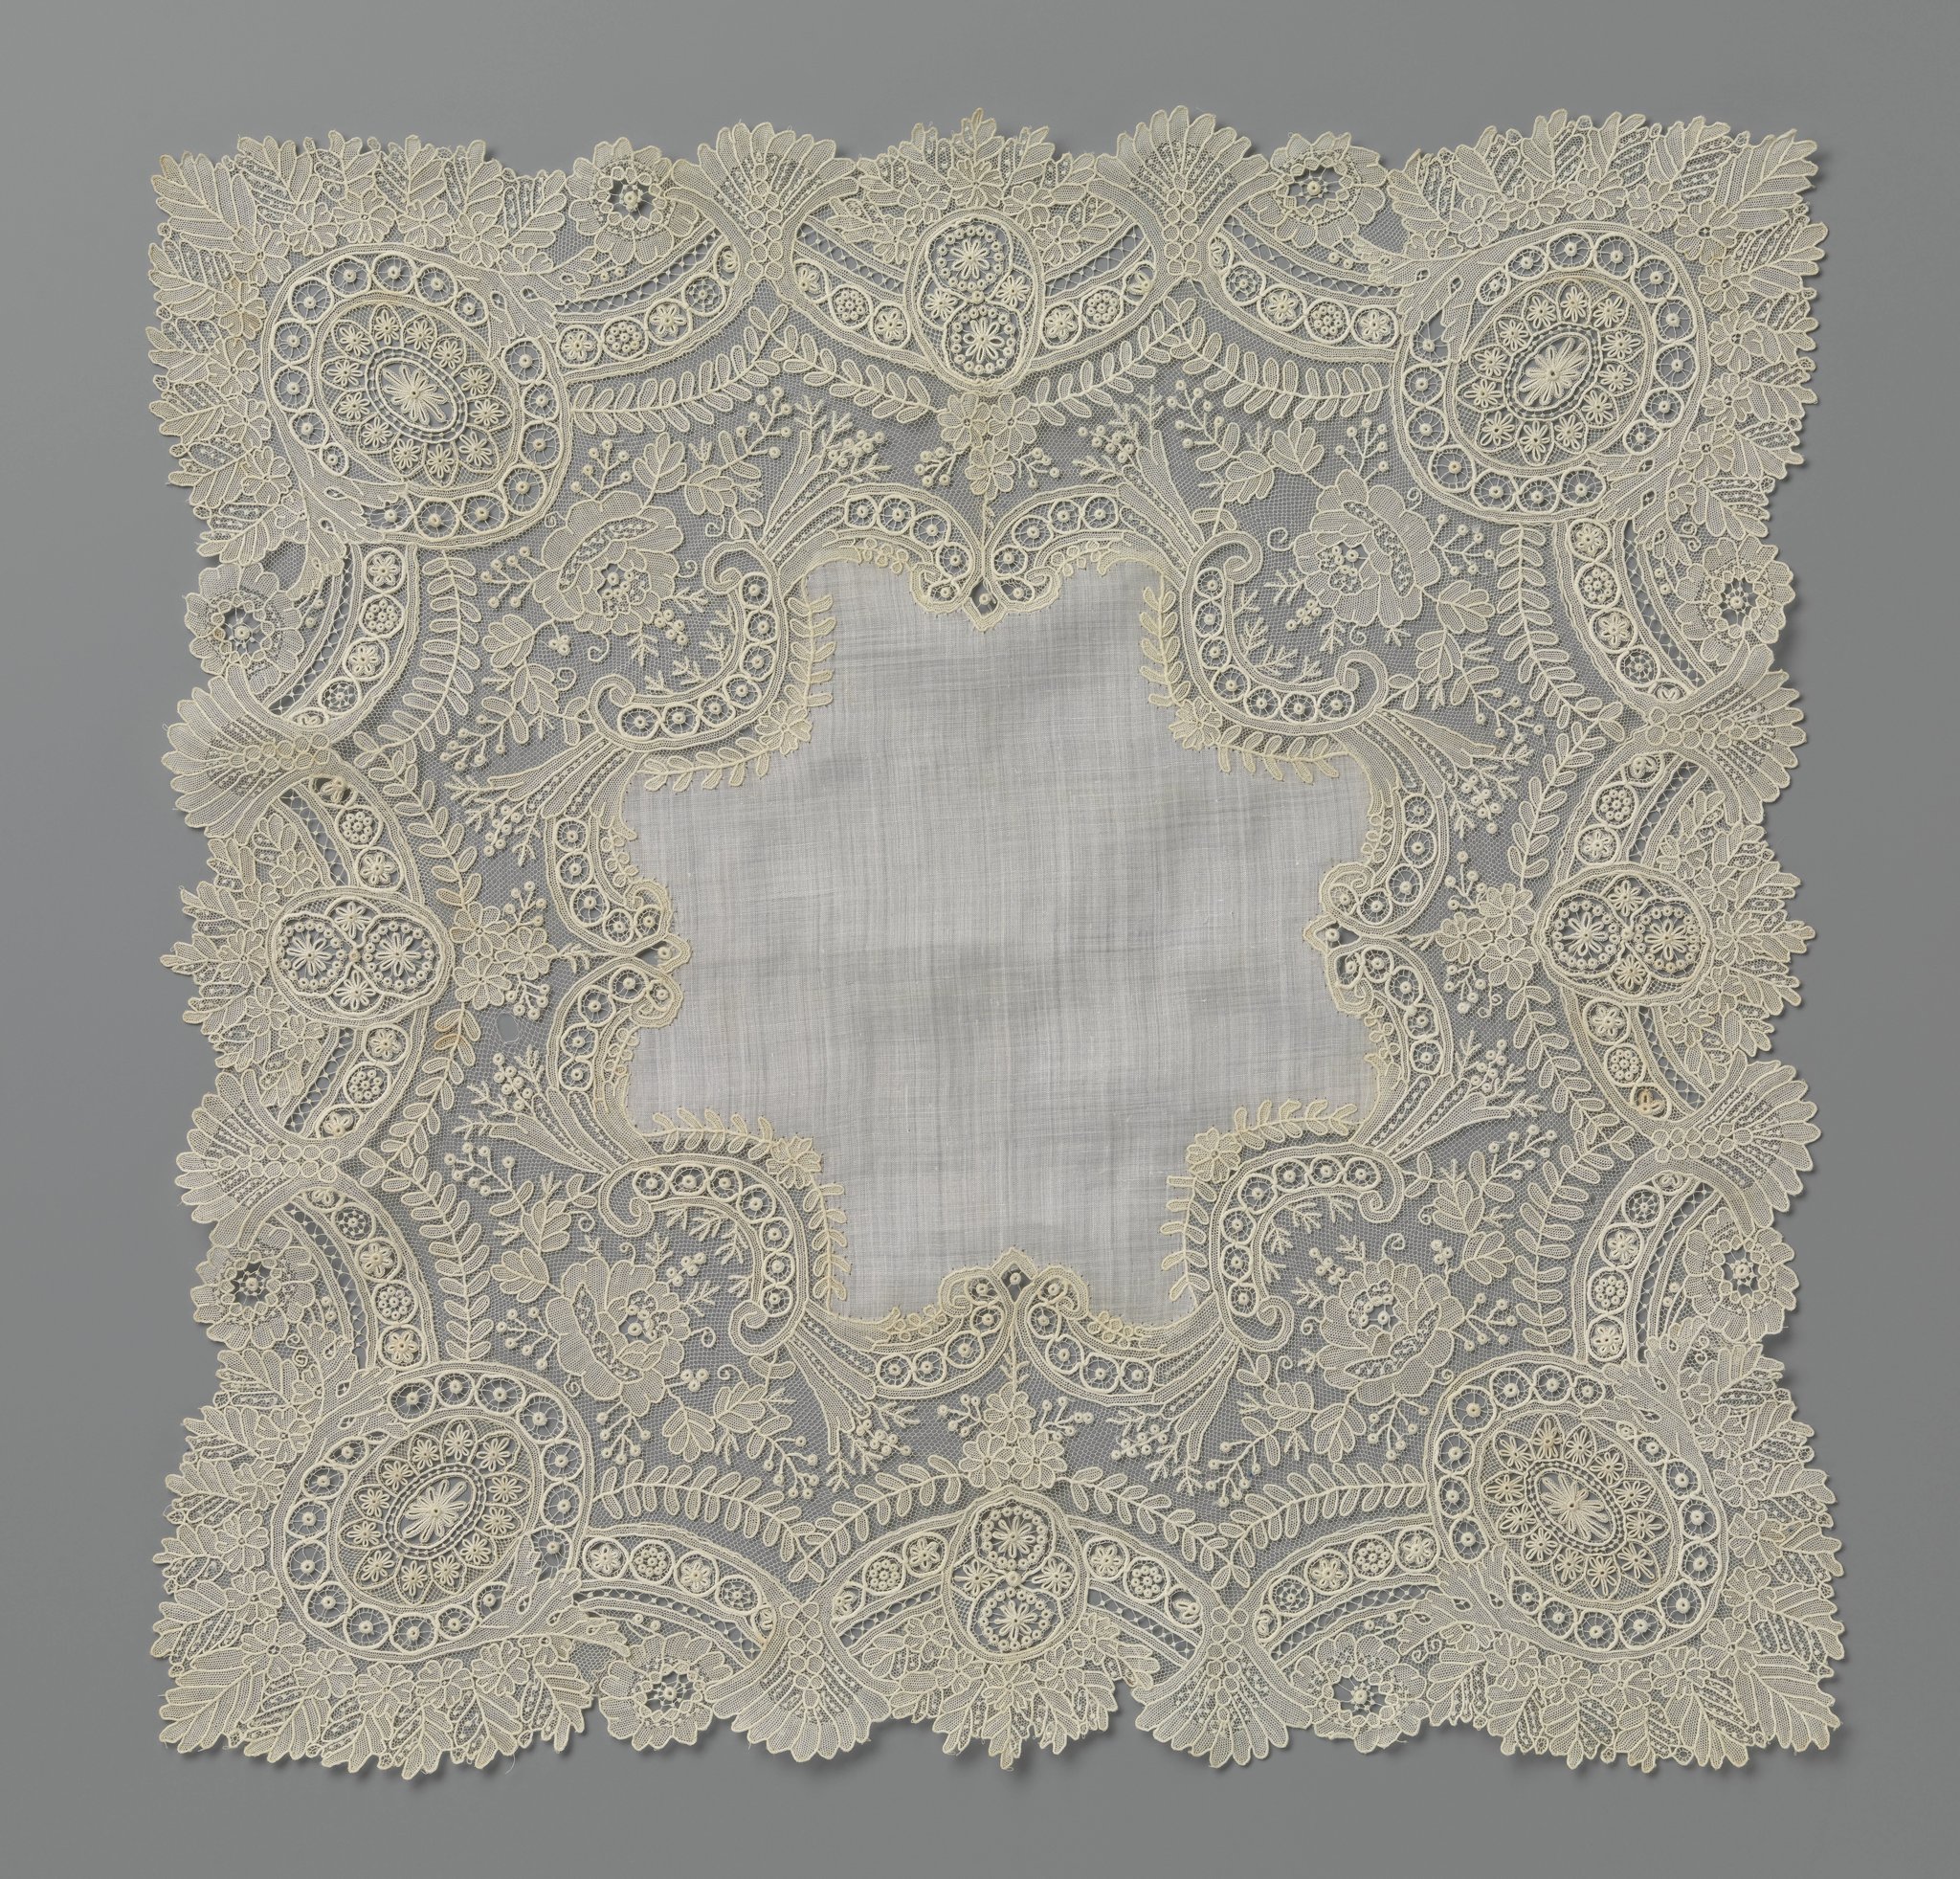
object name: handkerchief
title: Zakdoek met een rand van naaldkant met vier grote en vier kleine ovalen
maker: Anonymous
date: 1870-1890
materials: linen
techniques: lace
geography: brussels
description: Zakdoek met een rand van naturelkleurige naaldkant, Brusselse gaaskant. Rondom een kruisvormig batisten midden loopt een brede rand van kant met holle schulpen, die worden oversneden door vier grote hoekovalen, afgewisseld door vier kleinere. De schulpen zijn samengesteld uit 'spoorrails', een wieltjesrand en een bladtakje. De spitsen worden door een bladpalmetje bekroond. De met sterretjes en wieltjes gevulde ovalen worden afgesloten door een schulprand, die bestaat uit madeliefjes, waaronder blaadjes afhangen. Holle en bolle c-voluten vormen de binnenrand.